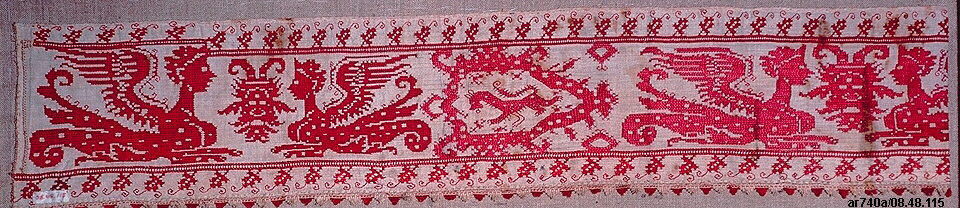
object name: border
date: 1601-1700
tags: mythical creatures